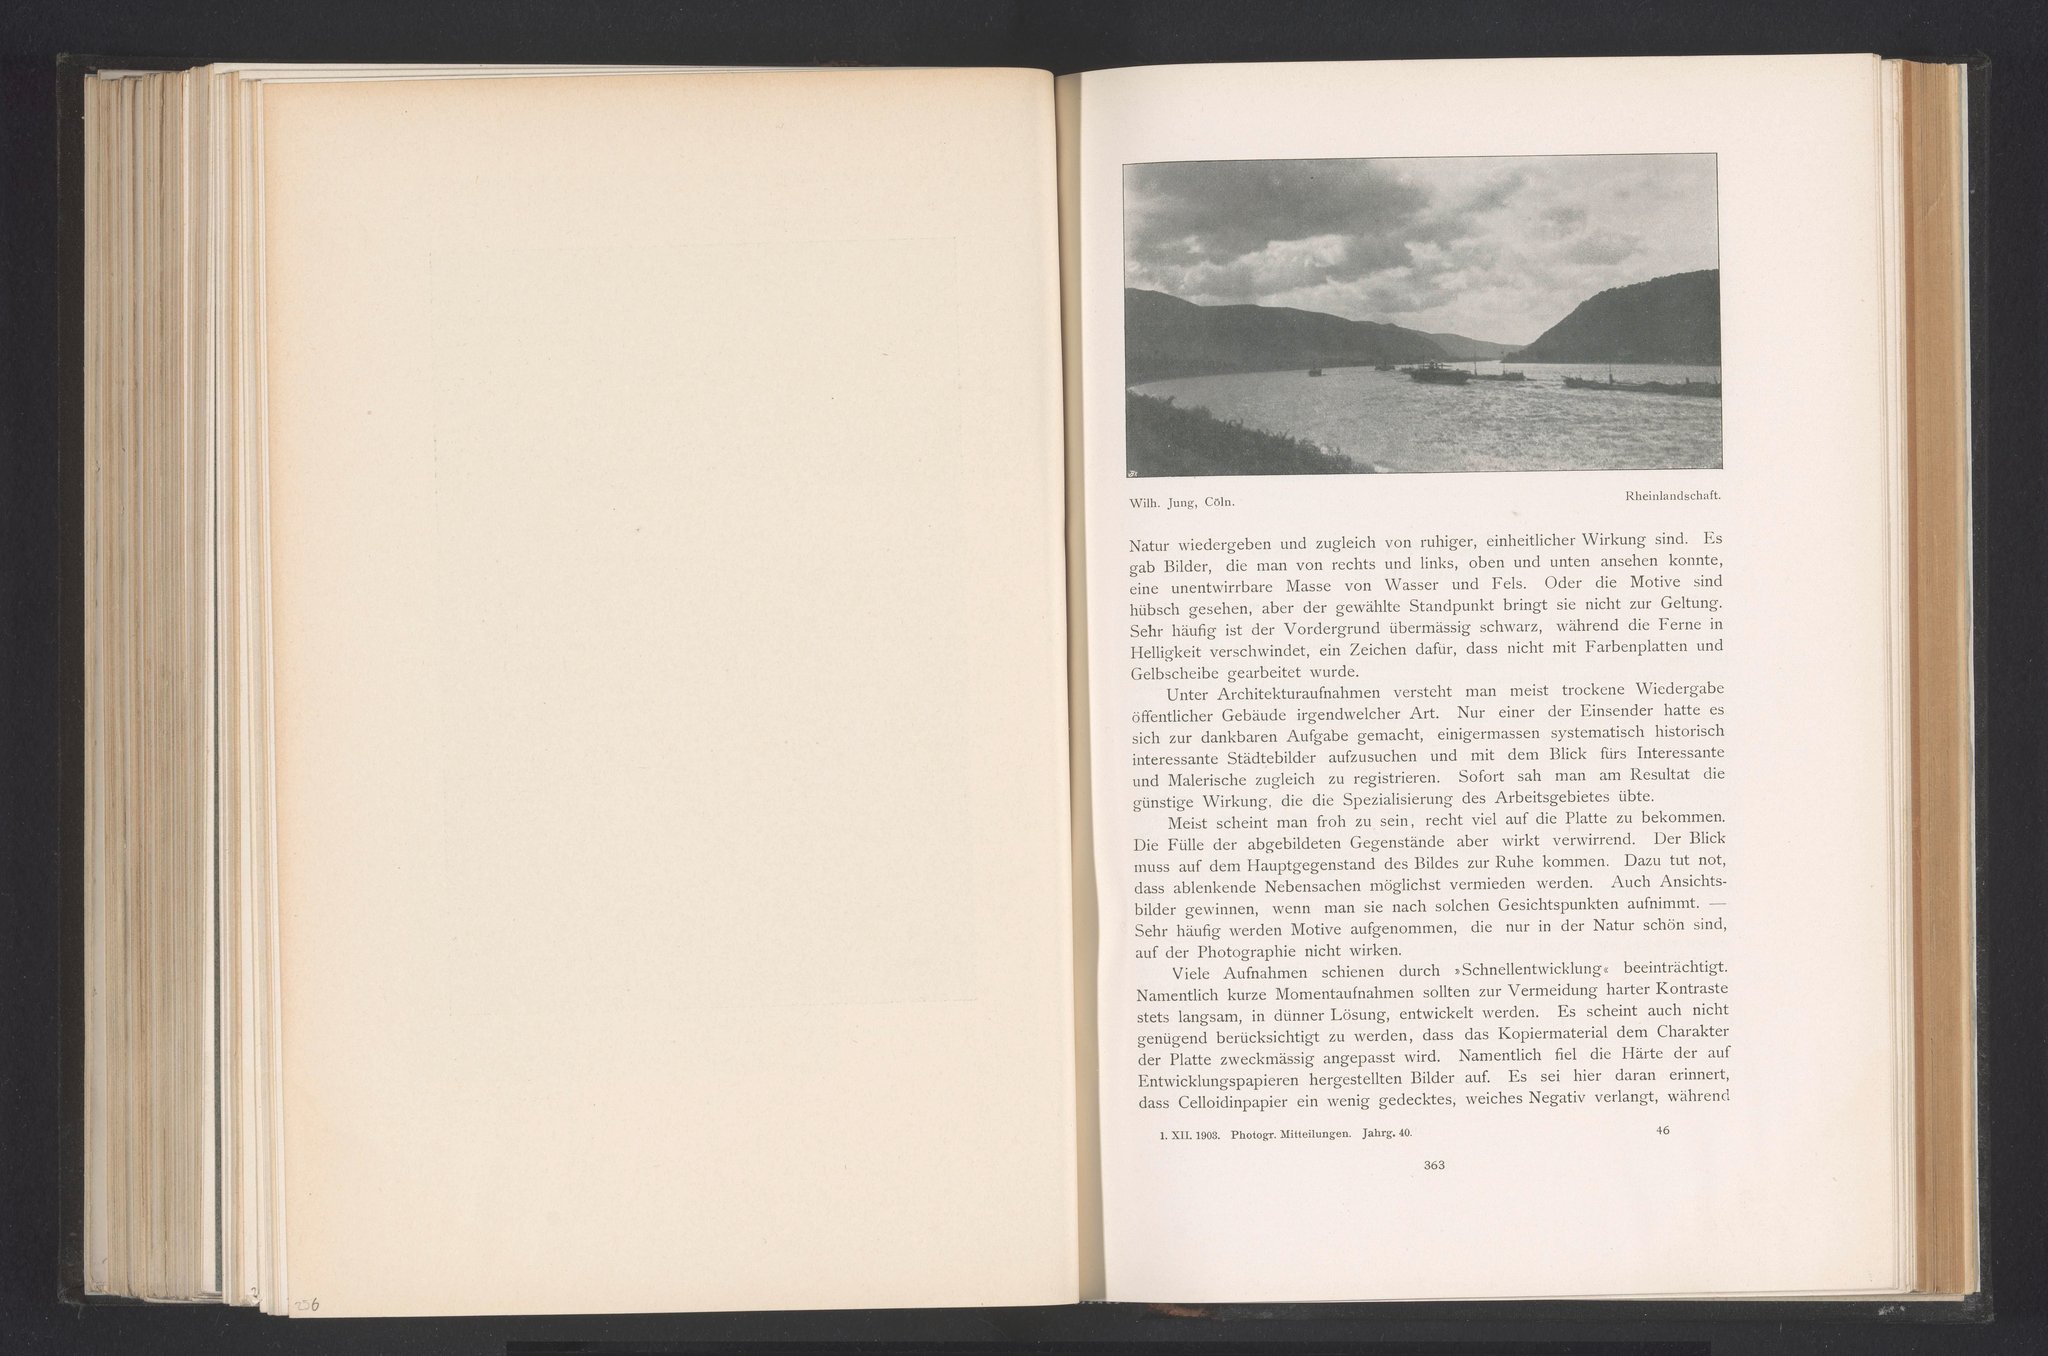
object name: photomechanical print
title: Gezicht op de Rijn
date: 1898-1903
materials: paper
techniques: autotype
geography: cologne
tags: landscapes, river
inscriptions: monogram: ‘BX’